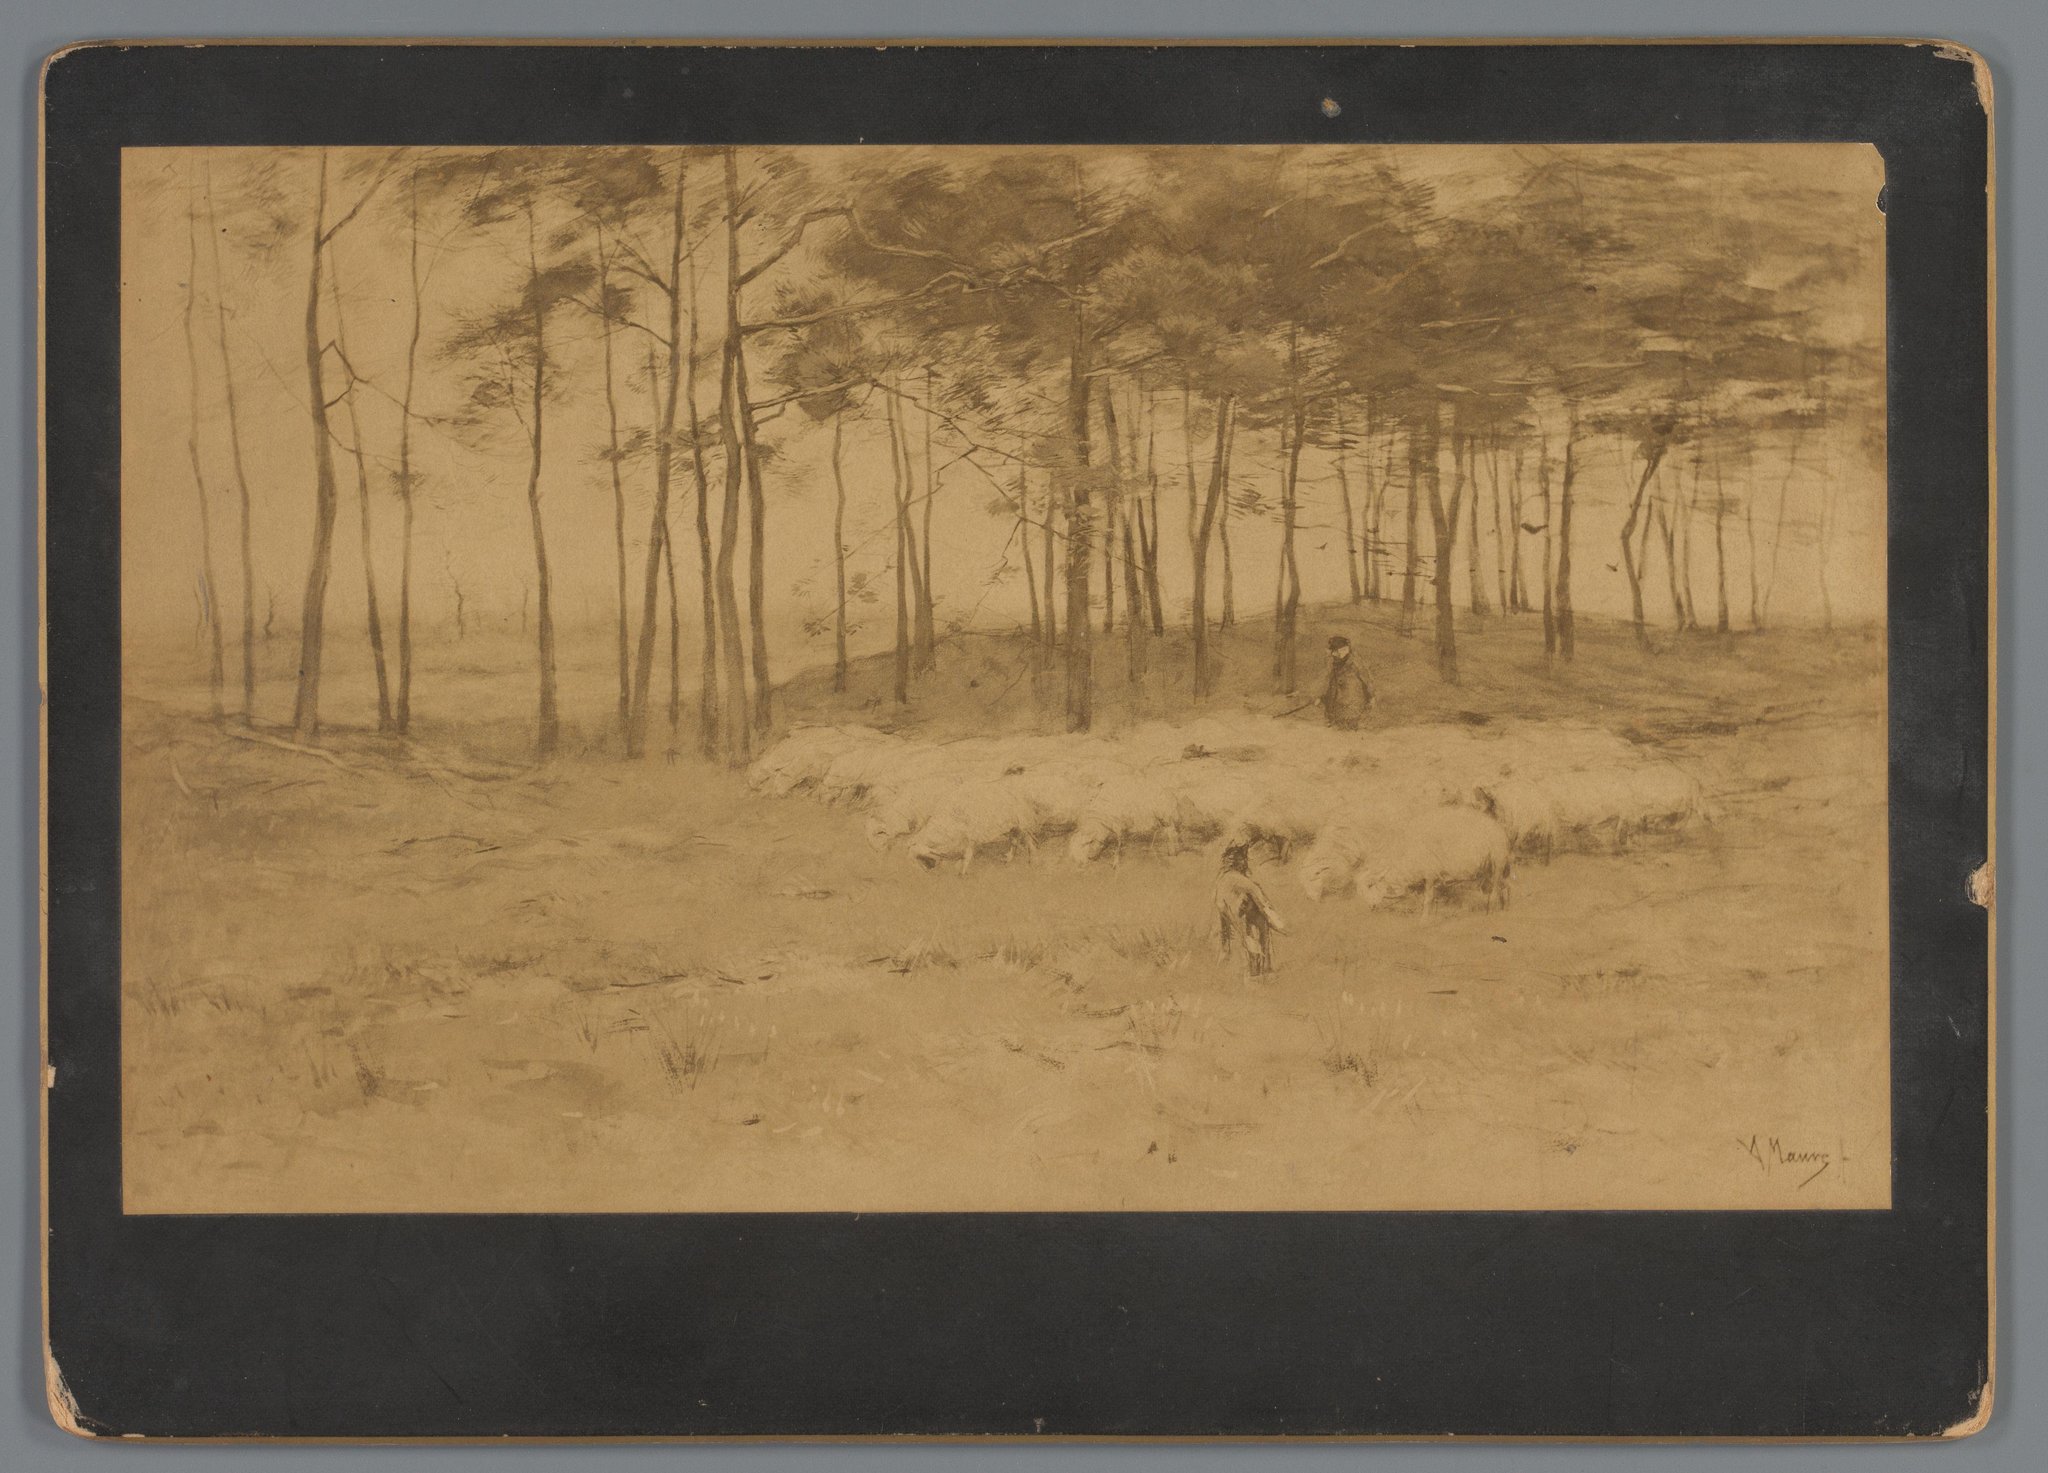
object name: reproduction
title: Fotoreproductie van een schilderij van een herder met schapen bij een bosrand door Anton Mauve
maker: Anonymous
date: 1851-1900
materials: cardboard, paper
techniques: albumen print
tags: herding, herdsman, herdswoman, shepherd, shepherdess, cowherd, etc., fringe, edge of the wood, picture, painting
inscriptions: inscription: ‘97 A. Mauve./ Troupeau de brebis.’